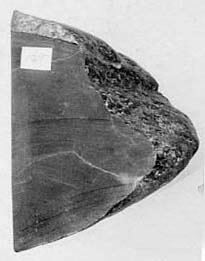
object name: fragment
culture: russian, siberia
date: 1902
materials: jade